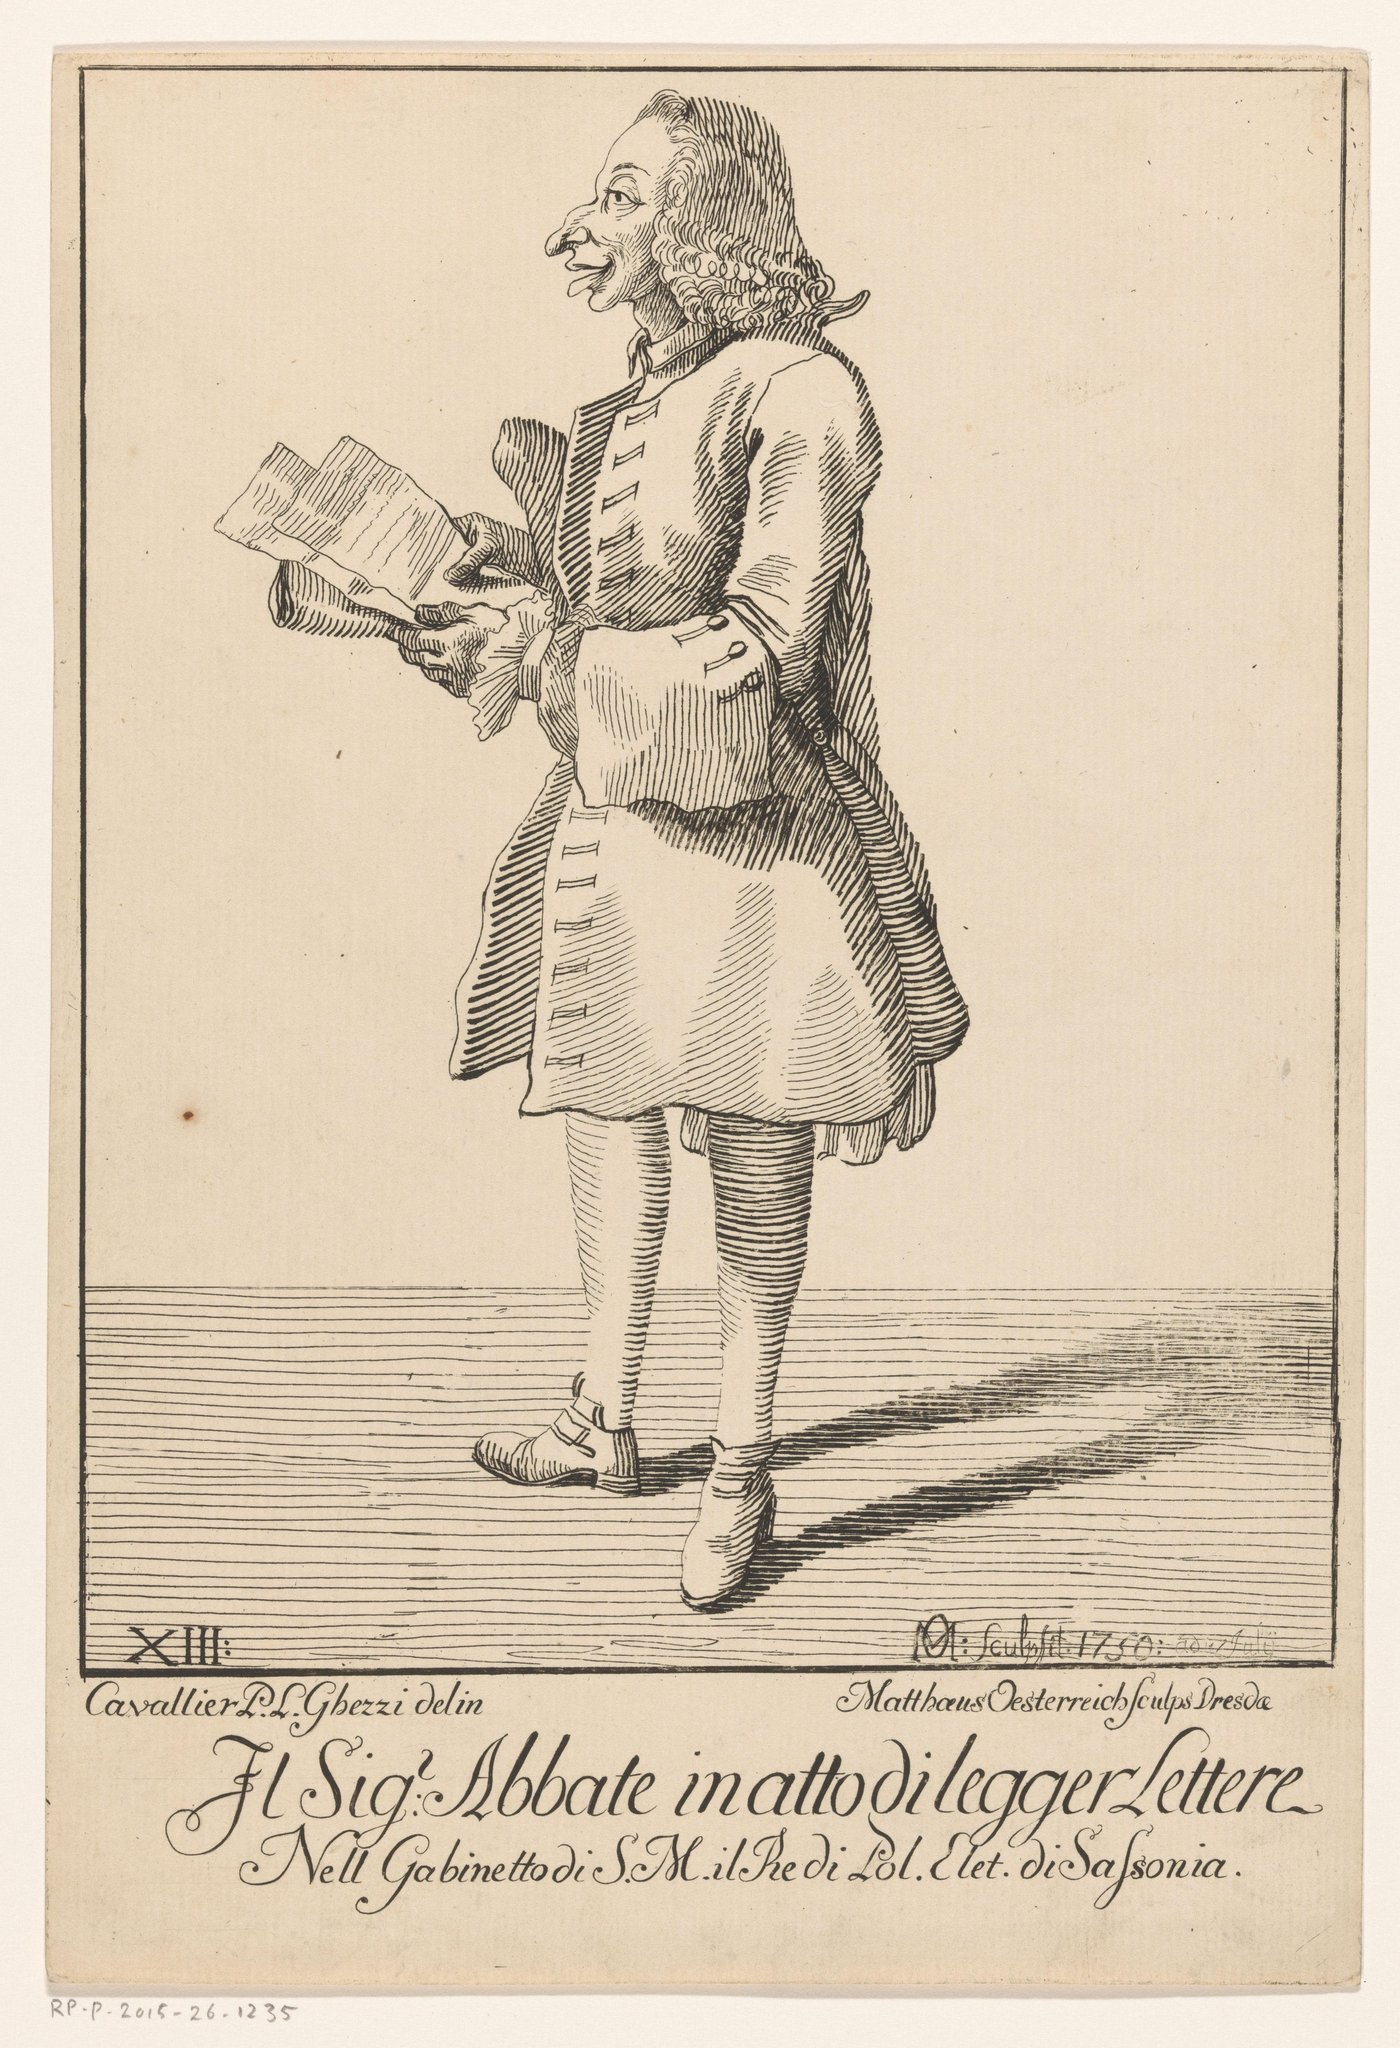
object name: print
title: Karikatuur van Abbate met een brief in zijn handen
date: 1750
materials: paper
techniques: etching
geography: dresden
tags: caricatures (human types), letter, envelope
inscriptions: collector's mark: Lugt 2228